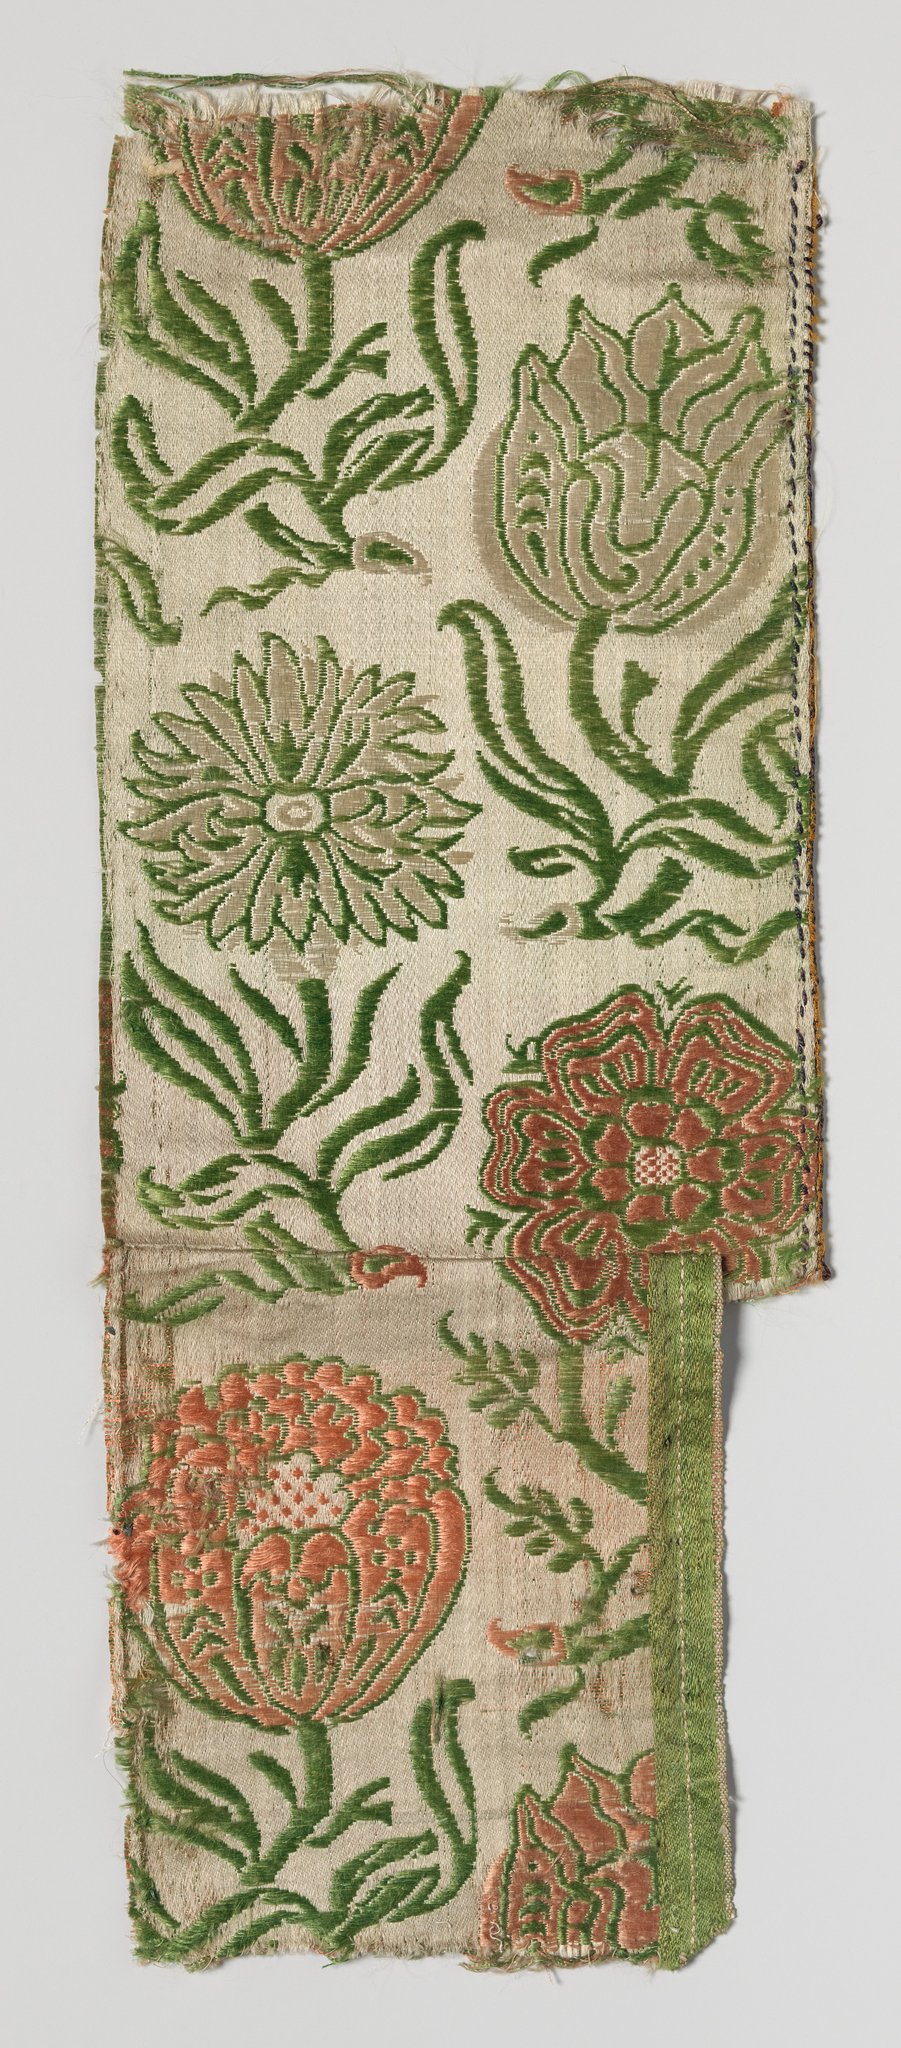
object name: fragment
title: Floral silk satin fragment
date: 1660-1680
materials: silk